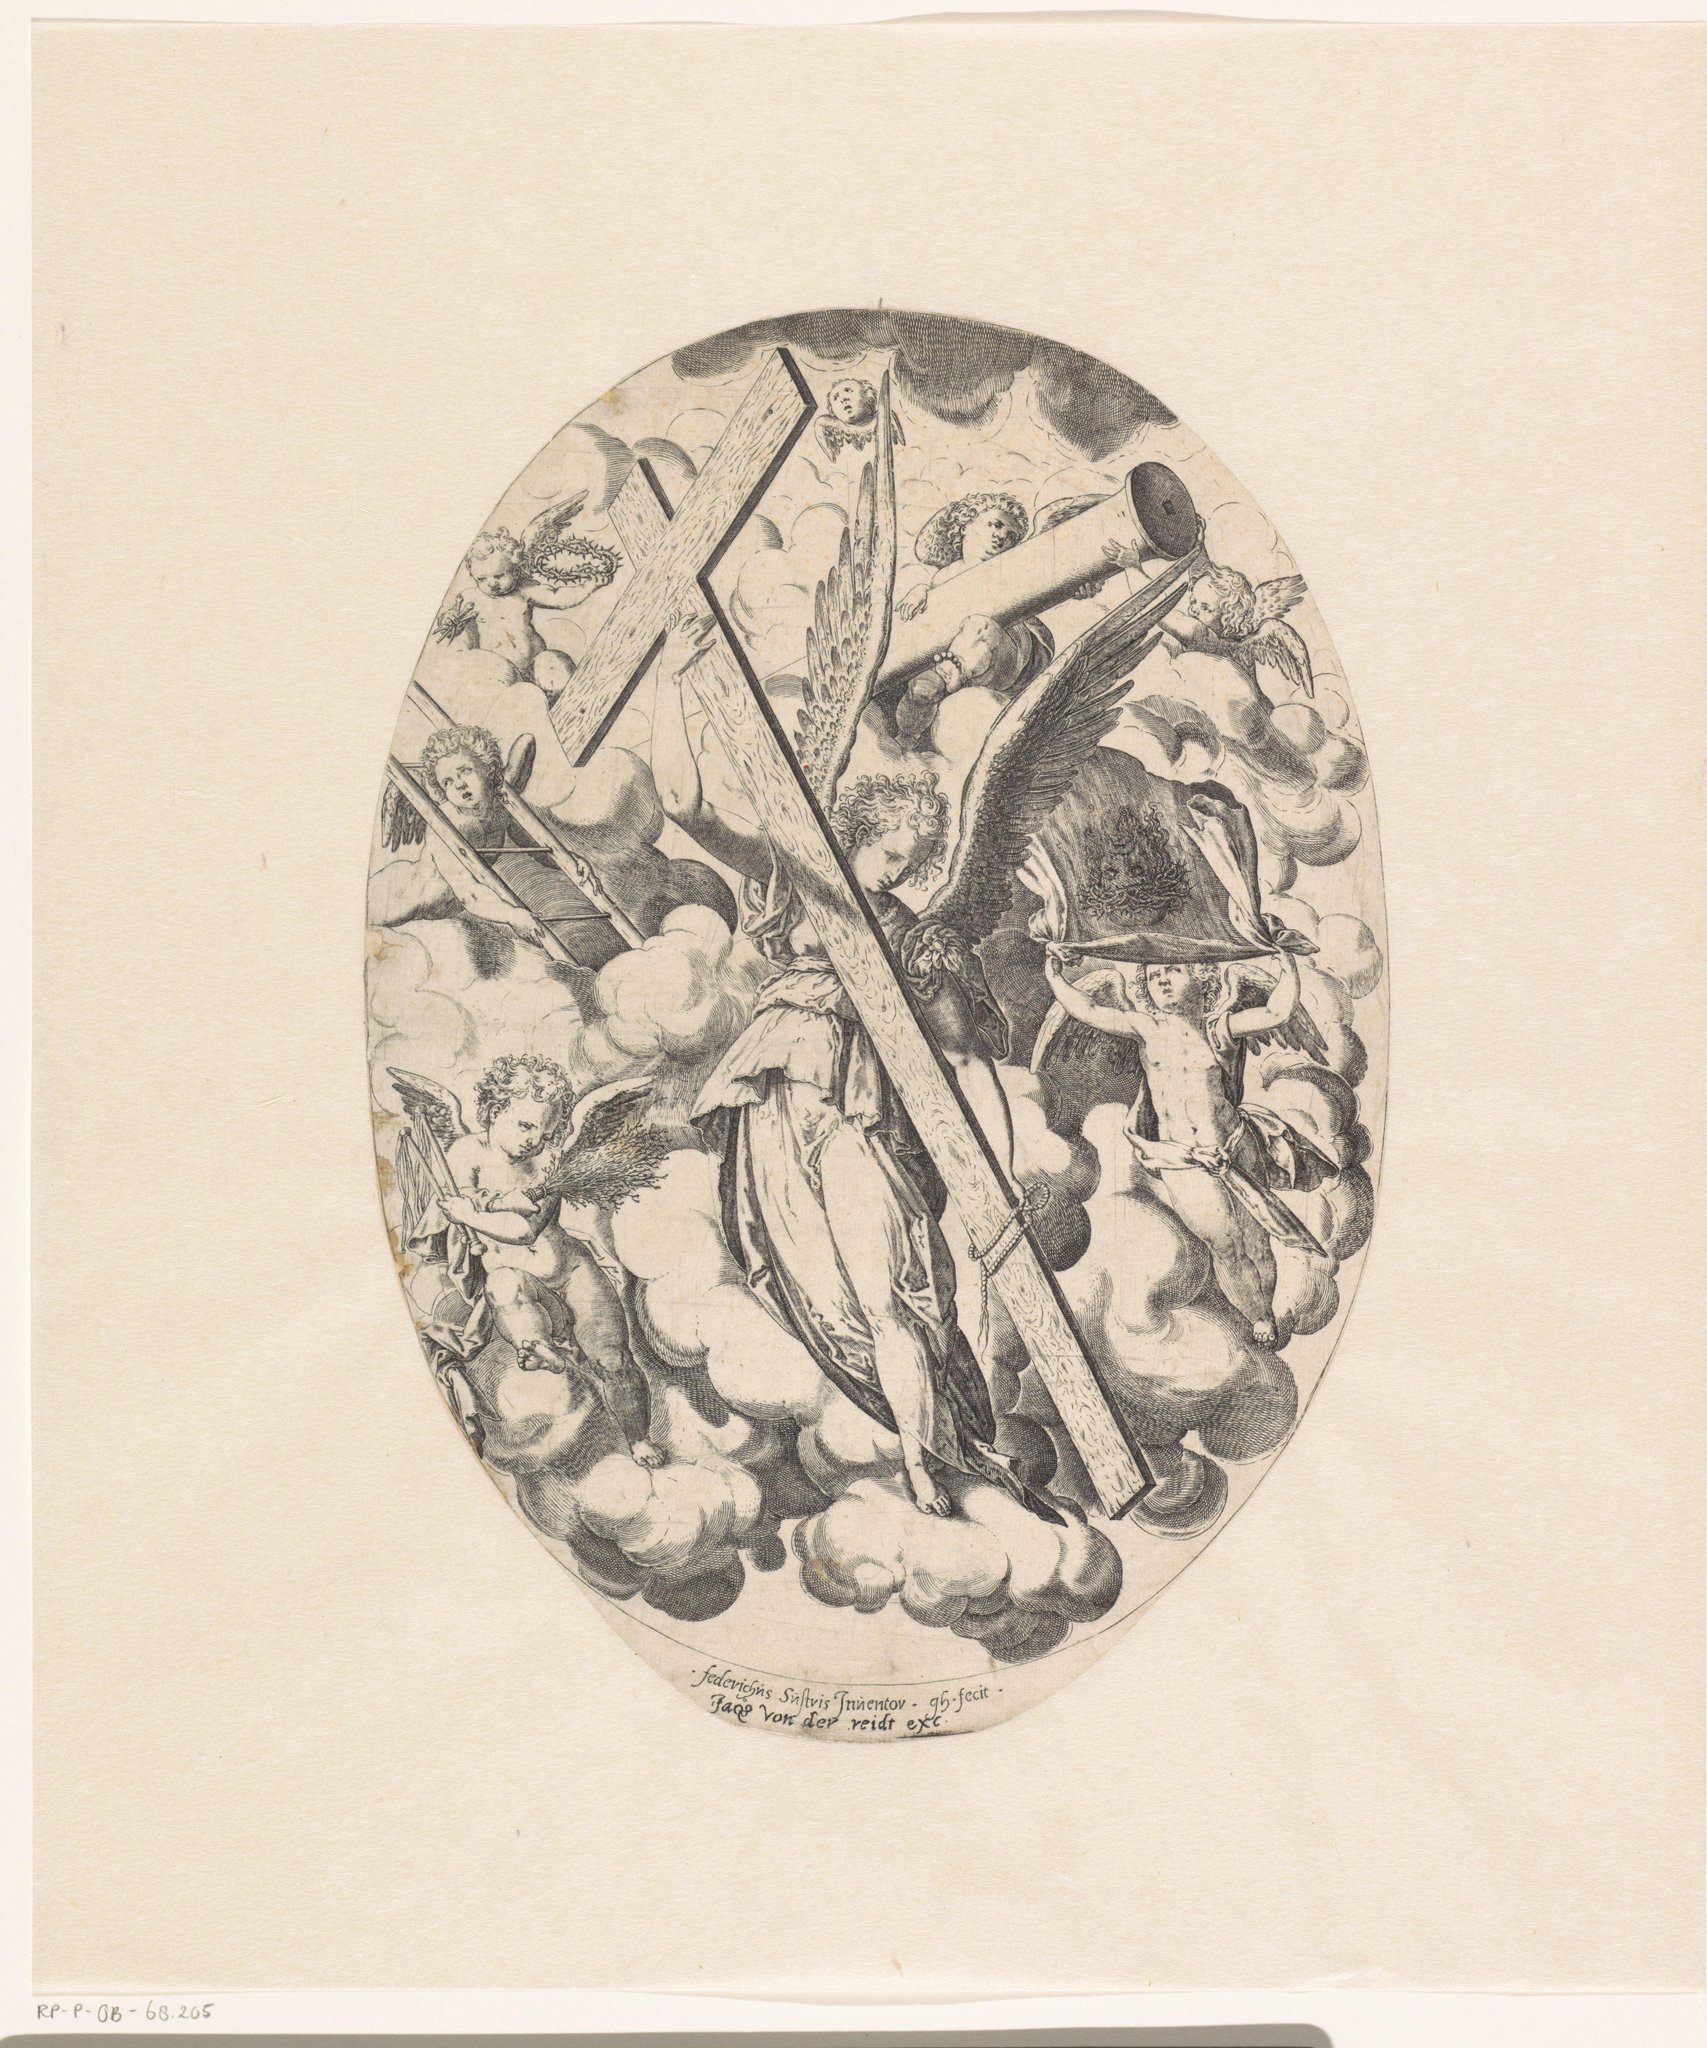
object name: print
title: Engelen met passiewerktuigen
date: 1600-1699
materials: paper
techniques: engraving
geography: low countries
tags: 'arma christi' (+ angel(s) floating in the air)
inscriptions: collector's mark: Lugt 2228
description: In de lucht zweven engelen met passiewerktuigen in hun handen: de ladder, spijkers, doornenkroon, geselzuil, veronicadoek en de gesels. In het midden een grote engel met het kruis.